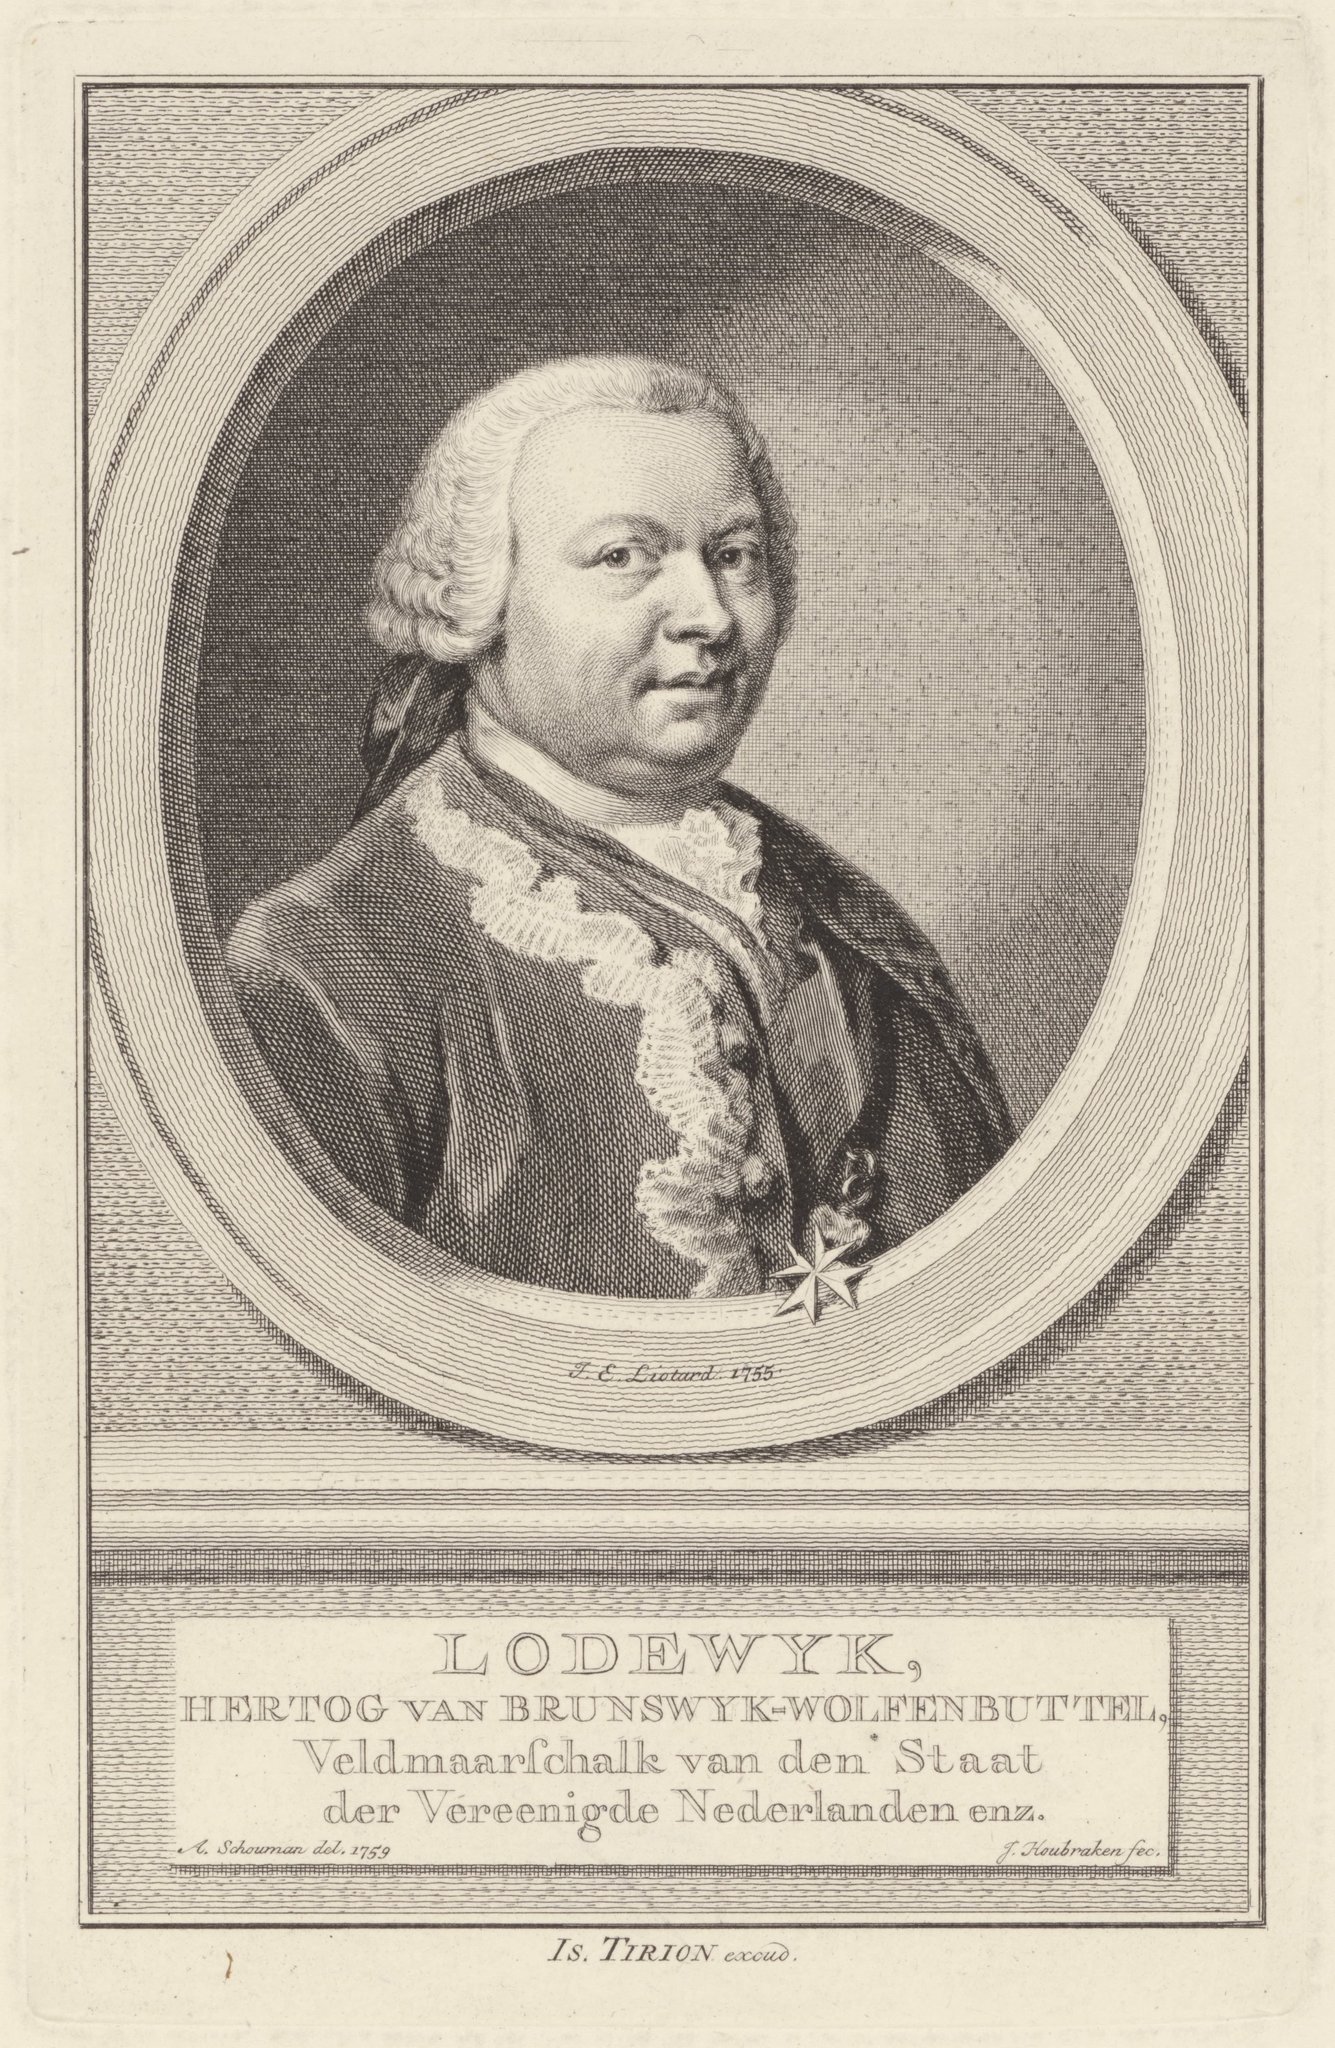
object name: print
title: Portret van Lodewijk Ernst, hertog van Brunswijk-Wolfenbüttel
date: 1759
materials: paper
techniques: engraving, etching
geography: amsterdam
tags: ludwig ernst von braunschweig-wolfenbüttel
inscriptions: collector's mark: Lugt 2228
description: Prent ook gebruikt in: Jan Wagenaar, Vaderlandsche historie, vervattende de geschiedenissen der nu Vereenigde Nederlanden, inzonderheid die van Holland (...), 21 delen. Amsterdam, Isaak Tirion, 1749-59.